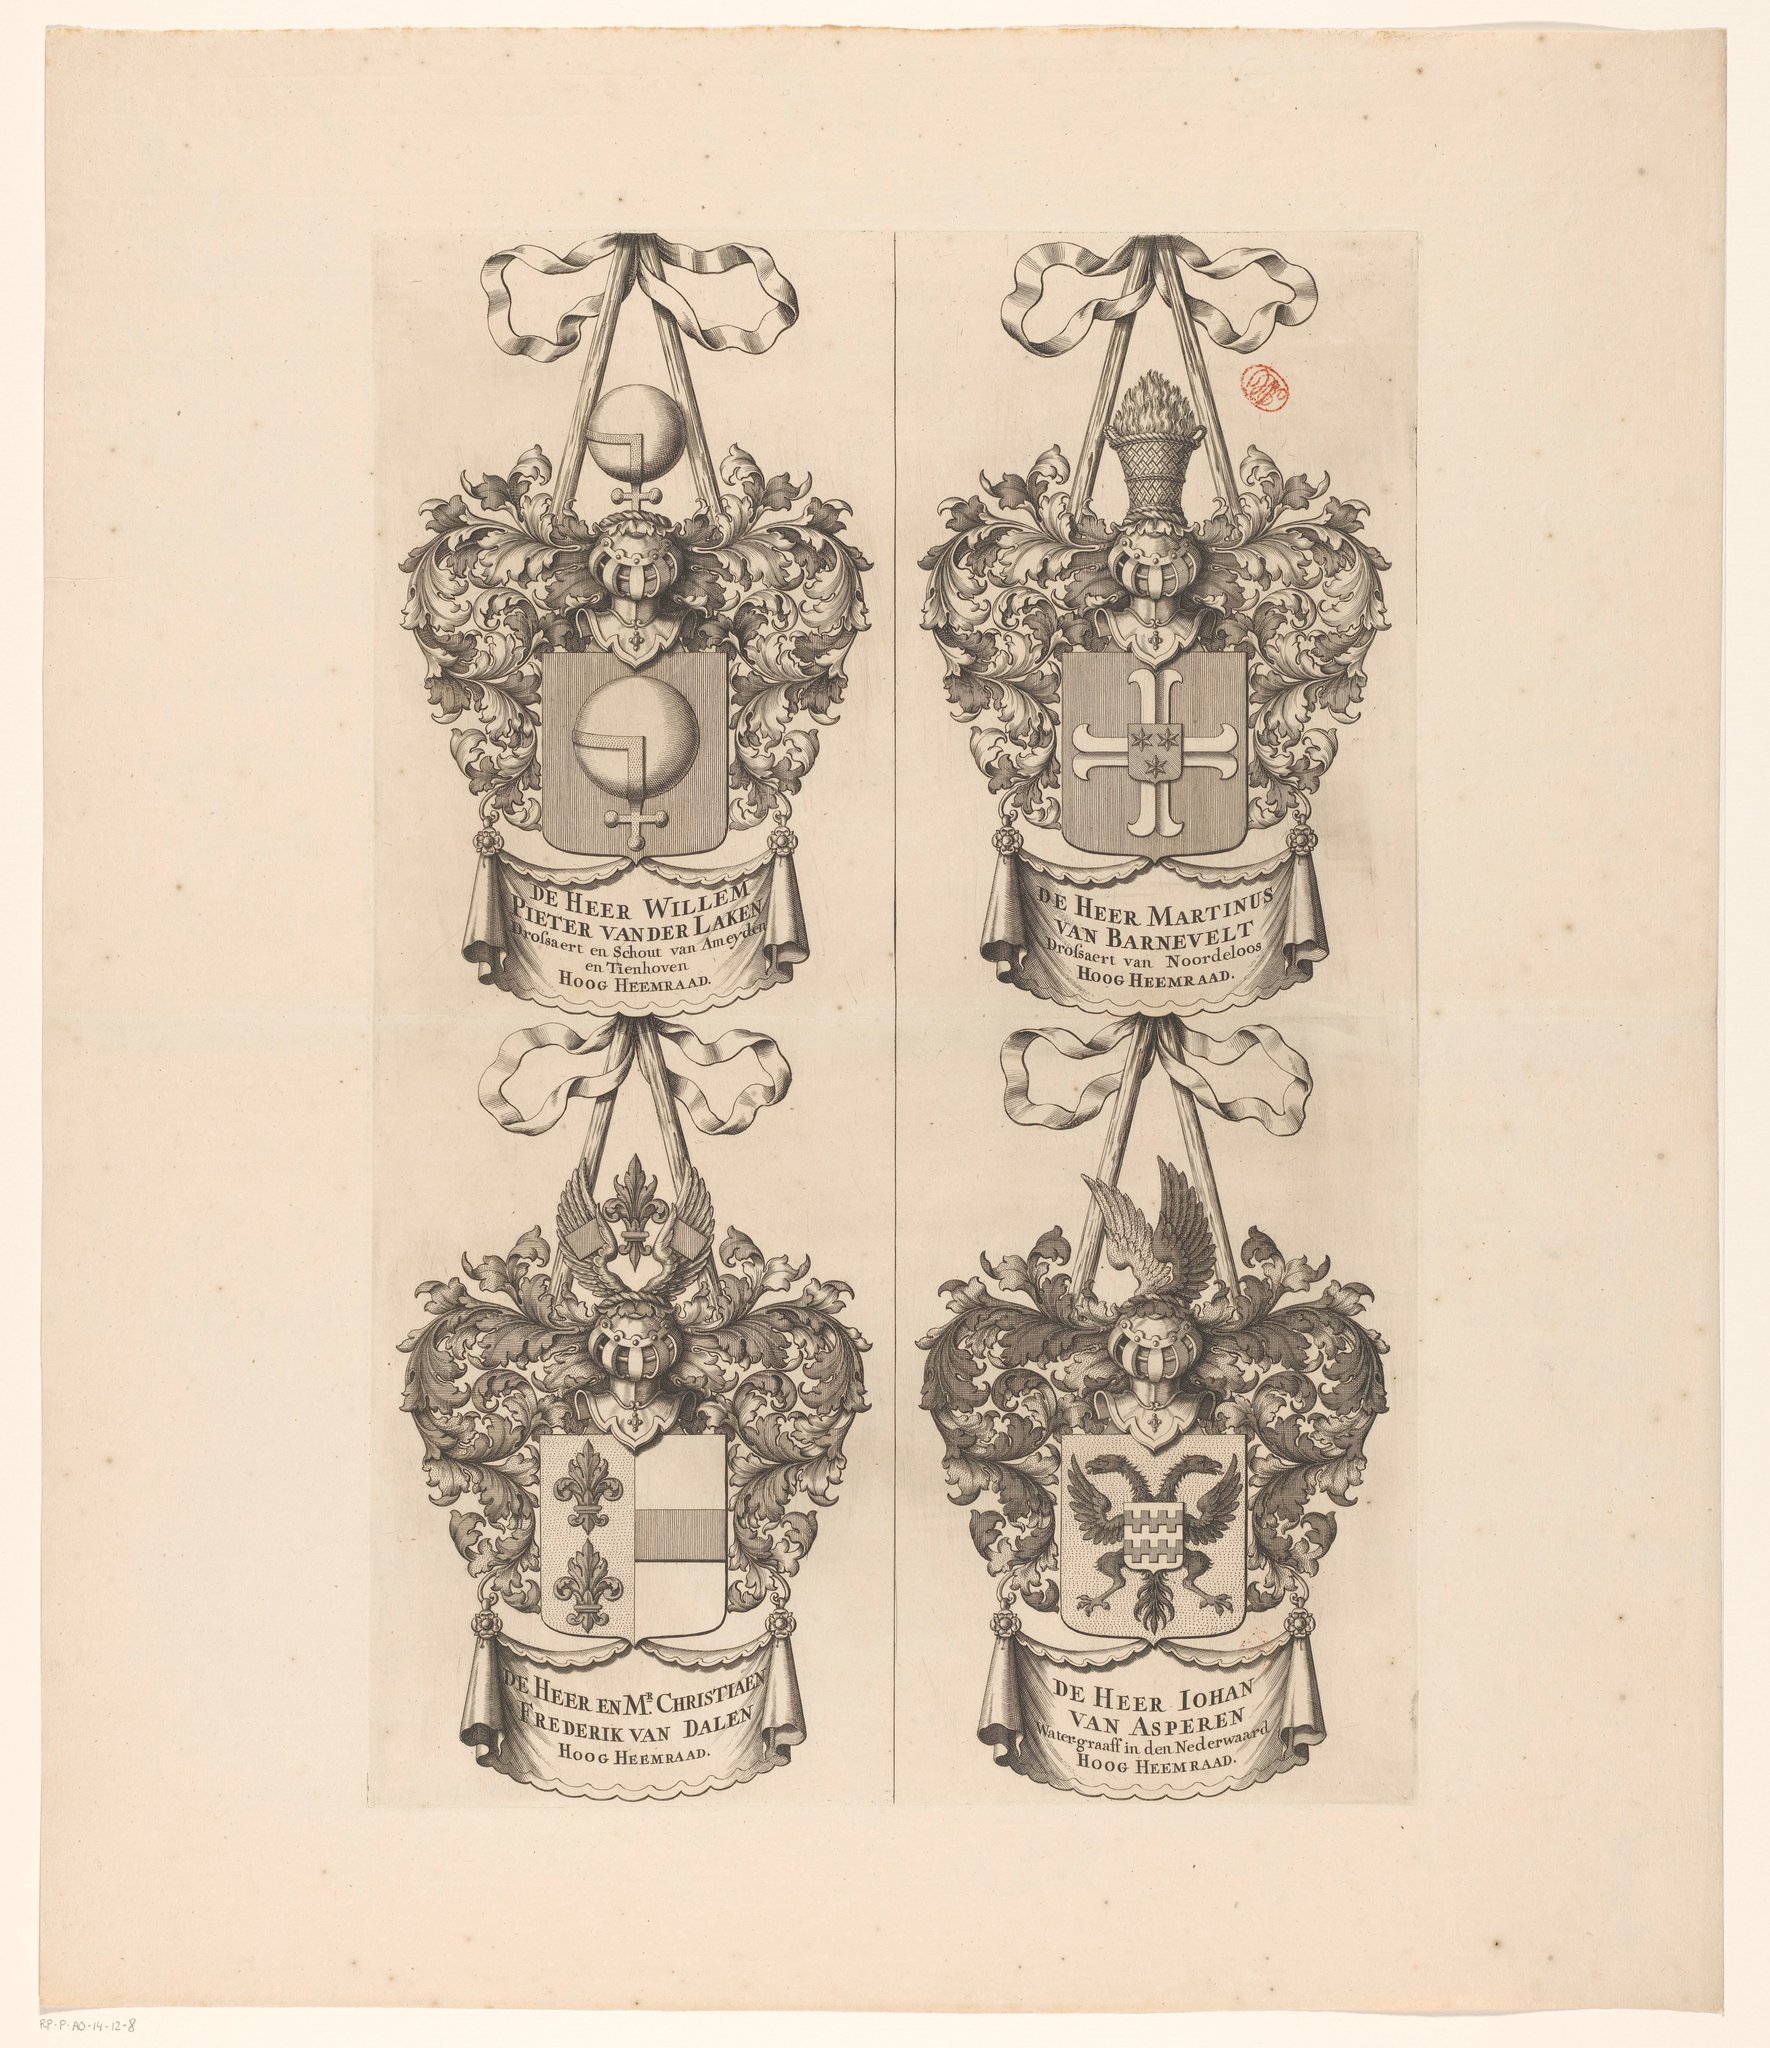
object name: print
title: Wapenrand van een kaart van de Alblasserwaard en de Vijfheerenlanden (deel)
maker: Anonymous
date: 1716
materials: paper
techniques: engraving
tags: armorial bearing, heraldry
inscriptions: collector's mark: Lugt 195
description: Deze prent is onderdeel van de wapenrand van de tweede druk (1716) van 'Den Alblasser Waard en Vyf Heeren Landen, te samen groot 33110. mergen / Nieuwe caerte vertoonende den geheelen Alblasserwaert', een vierdelige kaart van de Alblasserwaard en de Vijfheerenlanden (zie RP-P-AO-14-12). Van deze kaart zijn voor zover na te gaan vijf verschillende drukken bekend, uit respectievelijk 1681, 1716, 1730, 1741 en 1767. De kaart zelf is gedrukt van vier platen. In eerste instantie werden de wapens van de dijkgraaf, hoogheemraden en penningmeester/secretaris op de platen van de kaart gegraveerd. Voor de druk van 1716 werden deze wapenschilden van de platen afgesneden, werden de platen bijgewerkt en werd een aparte sierrand met de wapenschilden gemaakt. Voor de daaropvolgende drukken zou de wapenrand telkens aangepast en/of vernieuwd worden naar samenstelling van het bestuur van het hoogheemraadschap (waarschijnlijk werd de kaart telkens als een nieuwe dijkgraaf aantrad opnieuw uitgegeven met bijhorende wapenrand). Omdat er geen gemonteerde versie van de wapenrand bekend is en daarom onduidelijk is hoe deze er precies uit heeft gezien, is de wapenrand niet virtueel samengevoegd maar zijn de verschillende onderdelen wel te vinden onder RP-P-AO-14-12B.